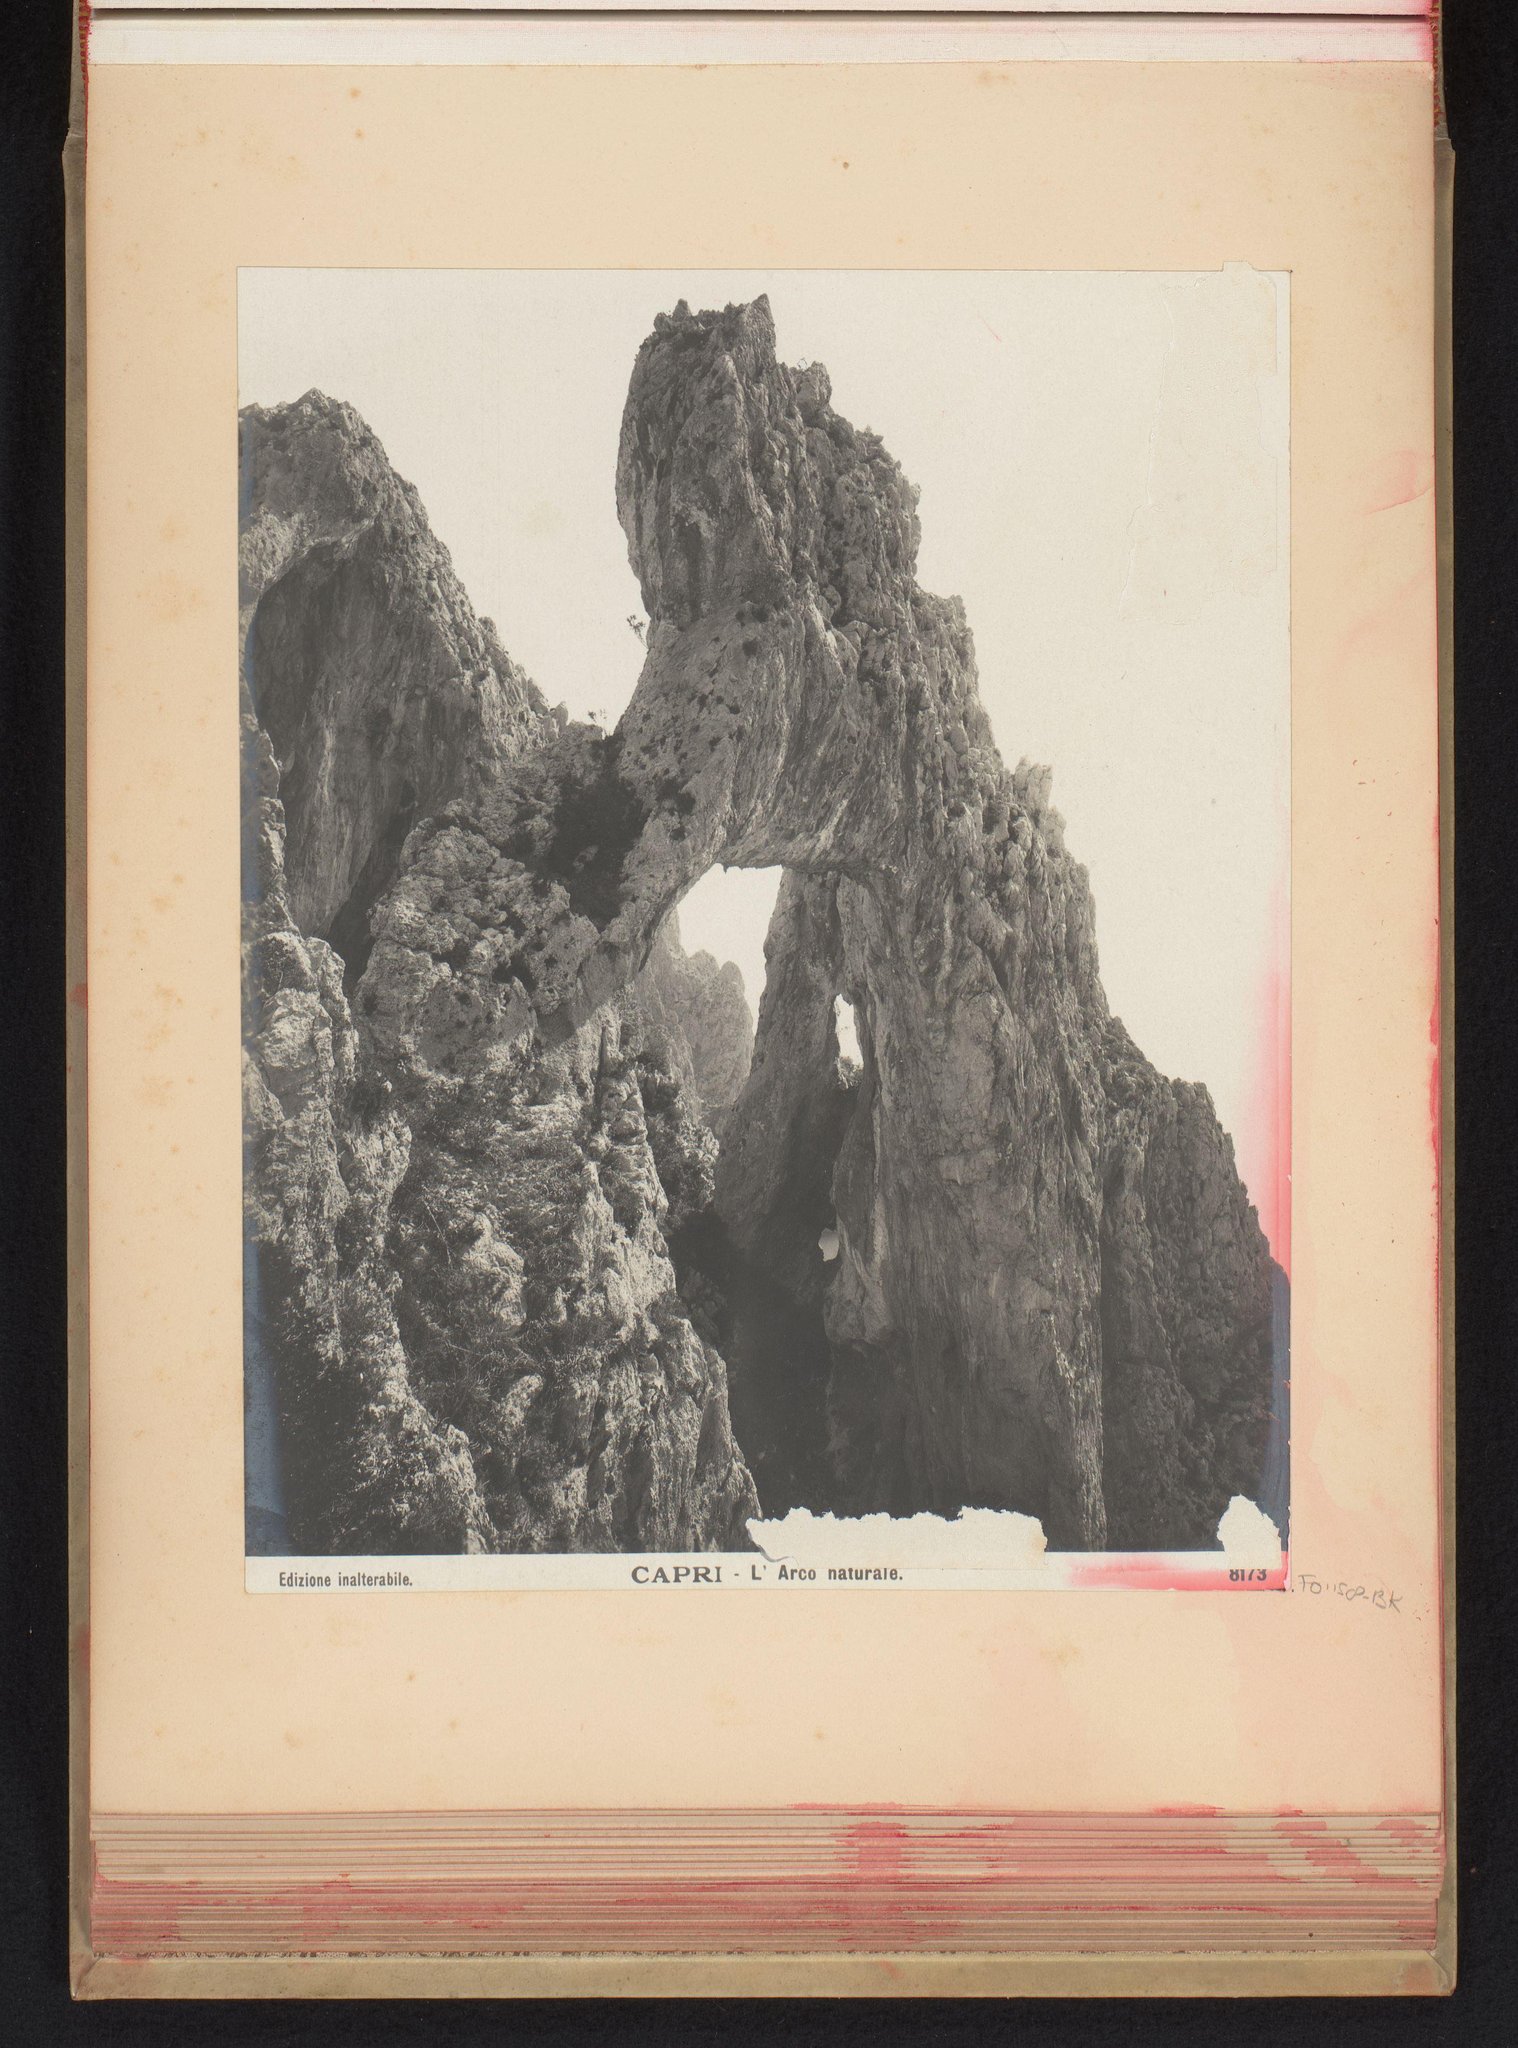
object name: photograph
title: Capri. l'Arco naturale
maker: Anonymous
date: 1875-1907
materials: photographic support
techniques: gelatin silver print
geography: capri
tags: rocky coast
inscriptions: number: ‘8173’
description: Onderdeel van Fotoalbum met opnames van bezienswaardigheden en kunstwerken in Italië.